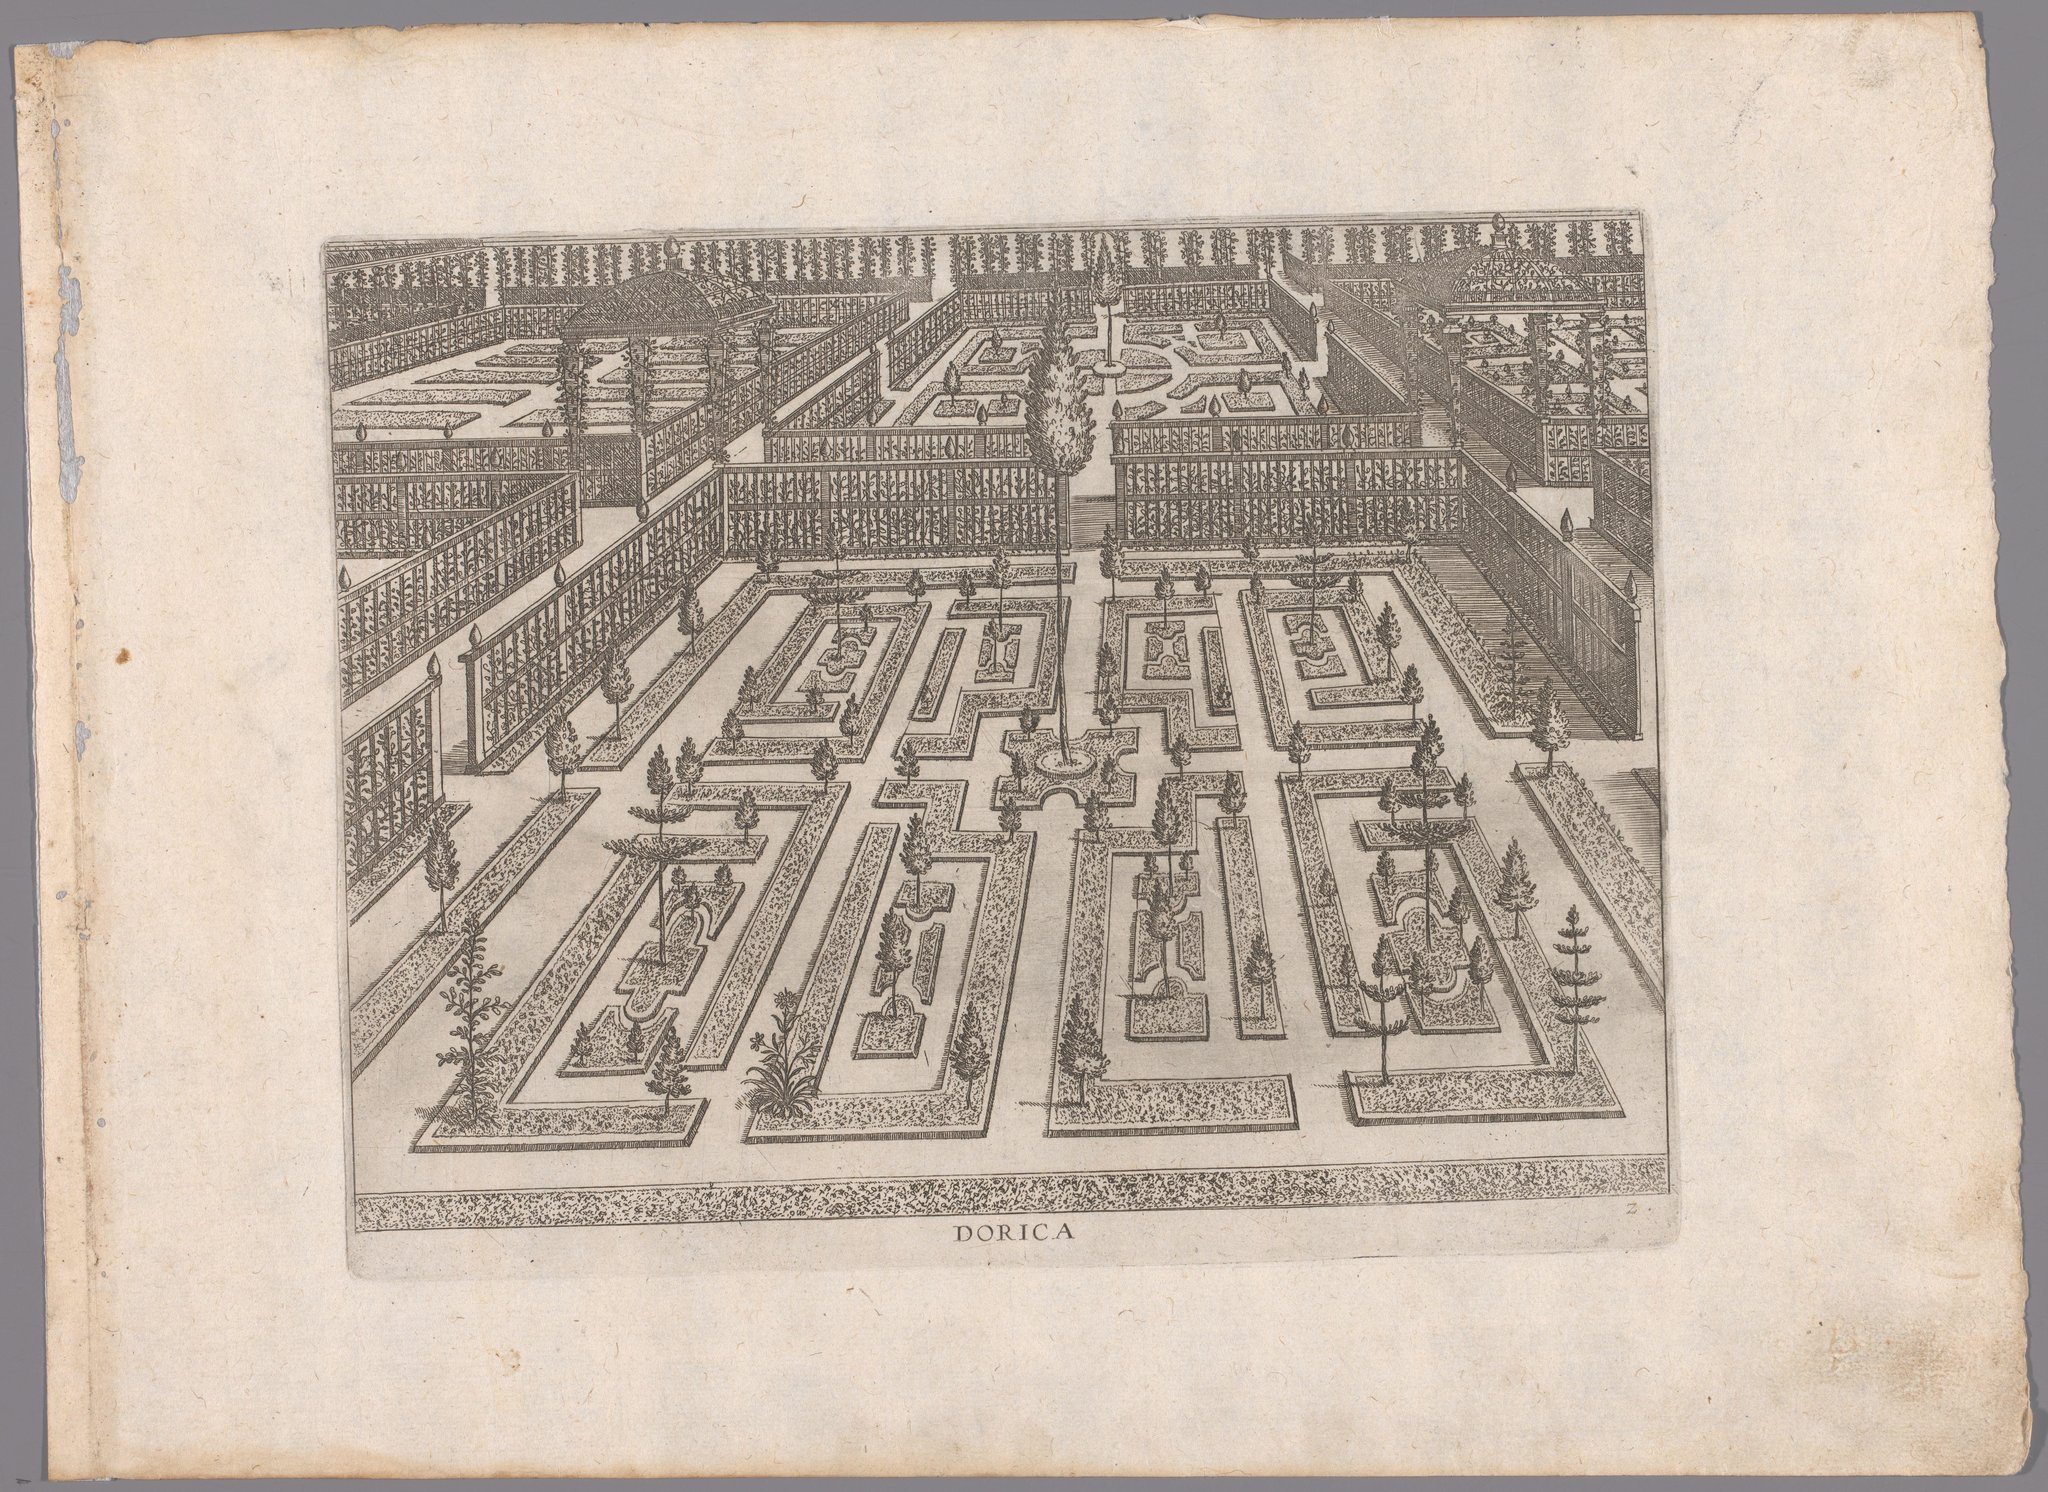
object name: print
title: Dorica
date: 1583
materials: paper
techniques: etching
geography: antwerp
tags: garden, french or architectonic garden; formal garden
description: Tuin met centrale parterre bestaande uit acht rechthoekige compartimenten. Omgeven door hekken waar planten tegenop groeien. De tuin is aangelegd volgens de Dorische bouworde.